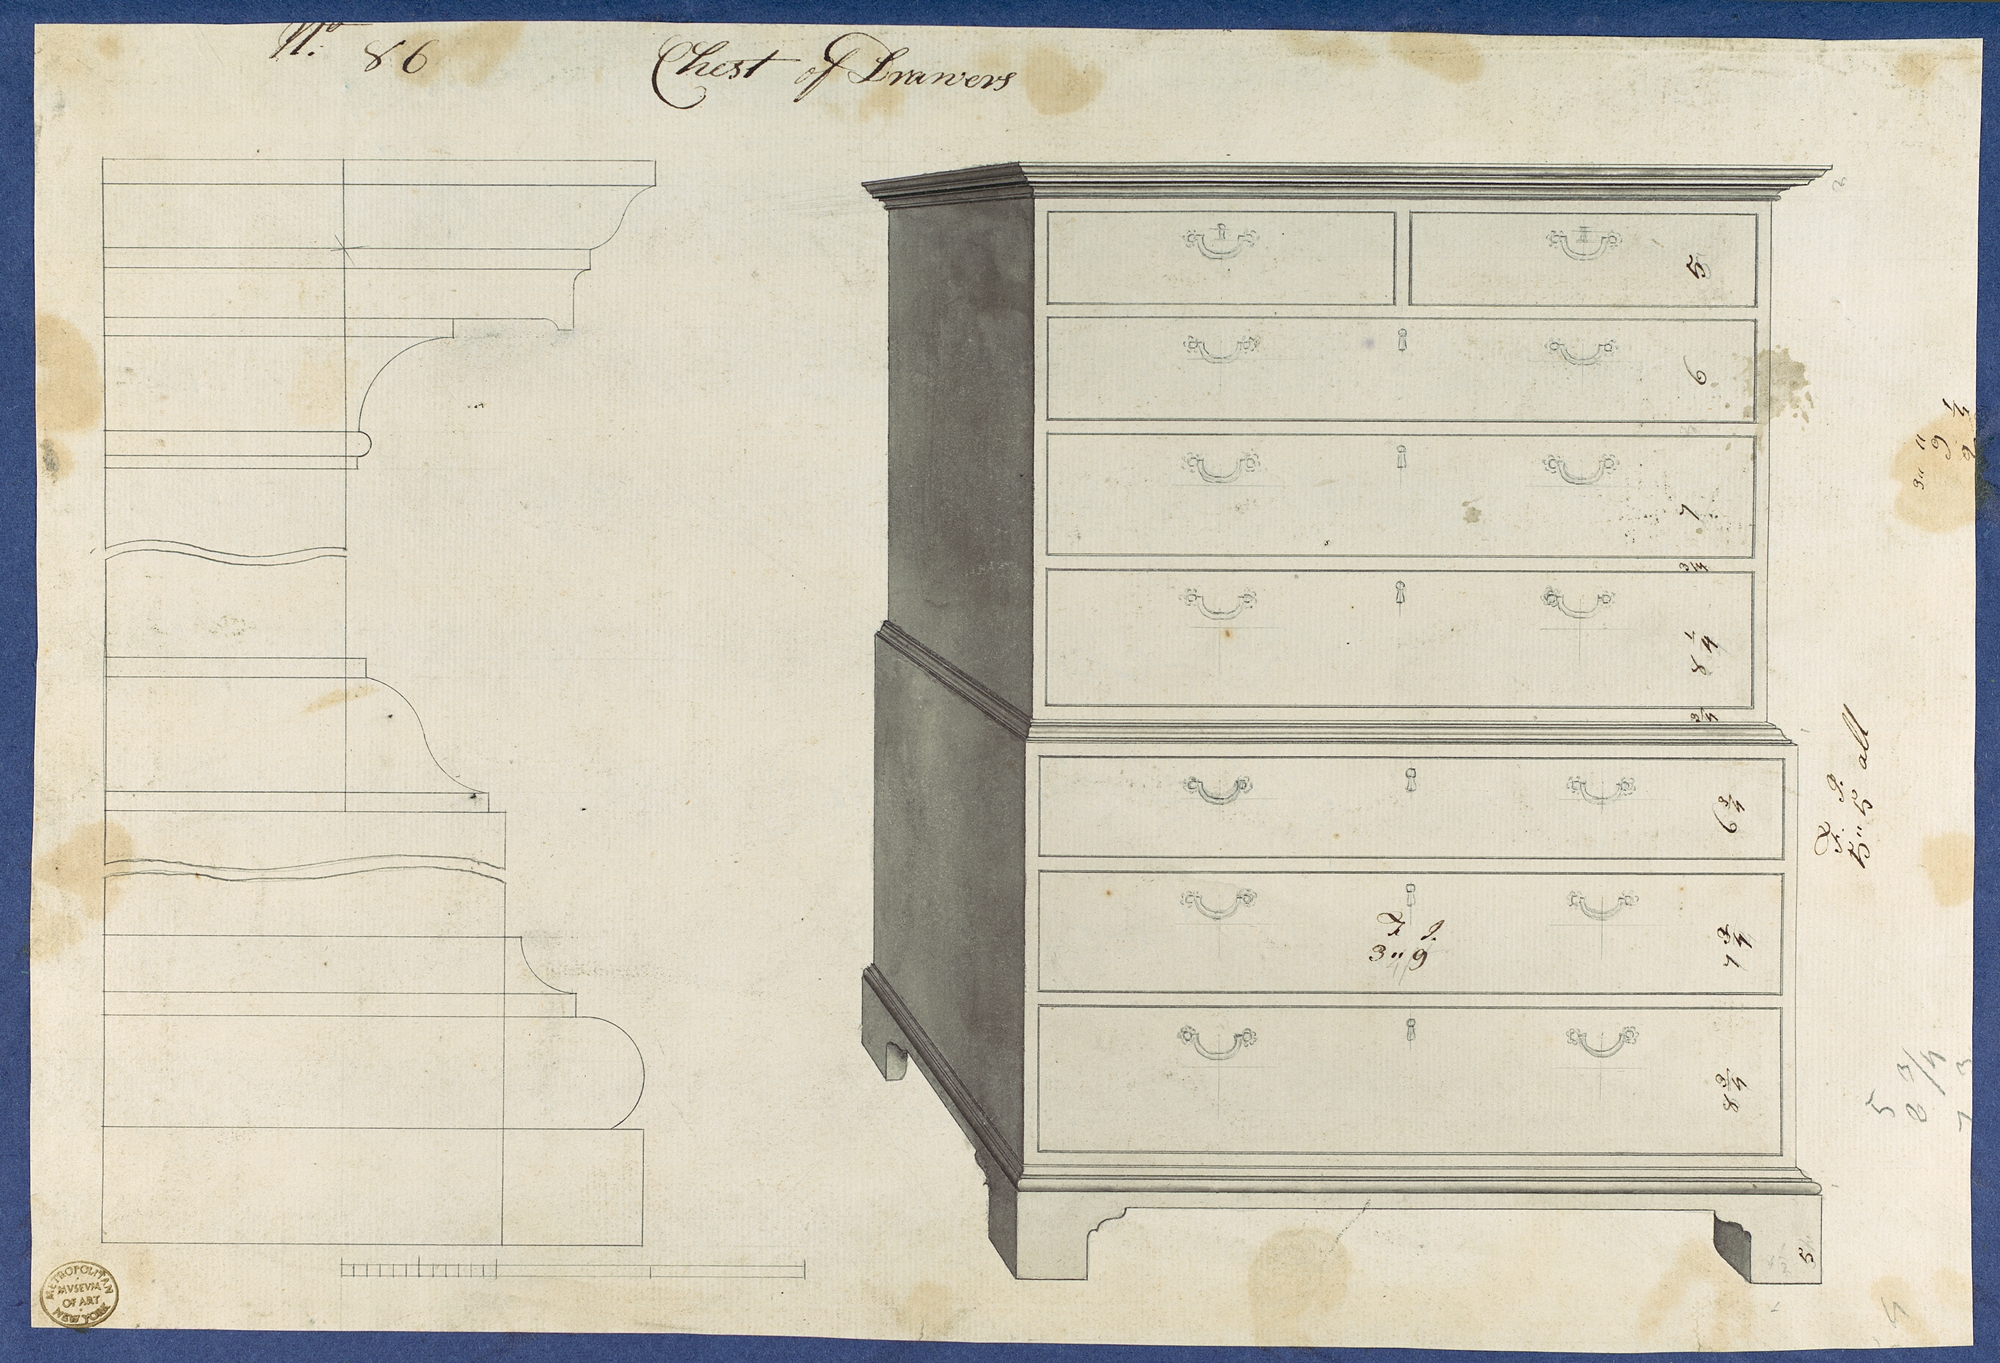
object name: drawing ornament architecture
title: Chest of Drawers, from Chippendale Drawings, Vol. II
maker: thomas chippendale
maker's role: artist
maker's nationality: british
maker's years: 1718-1779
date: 1753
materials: ink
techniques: wash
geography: london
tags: chests